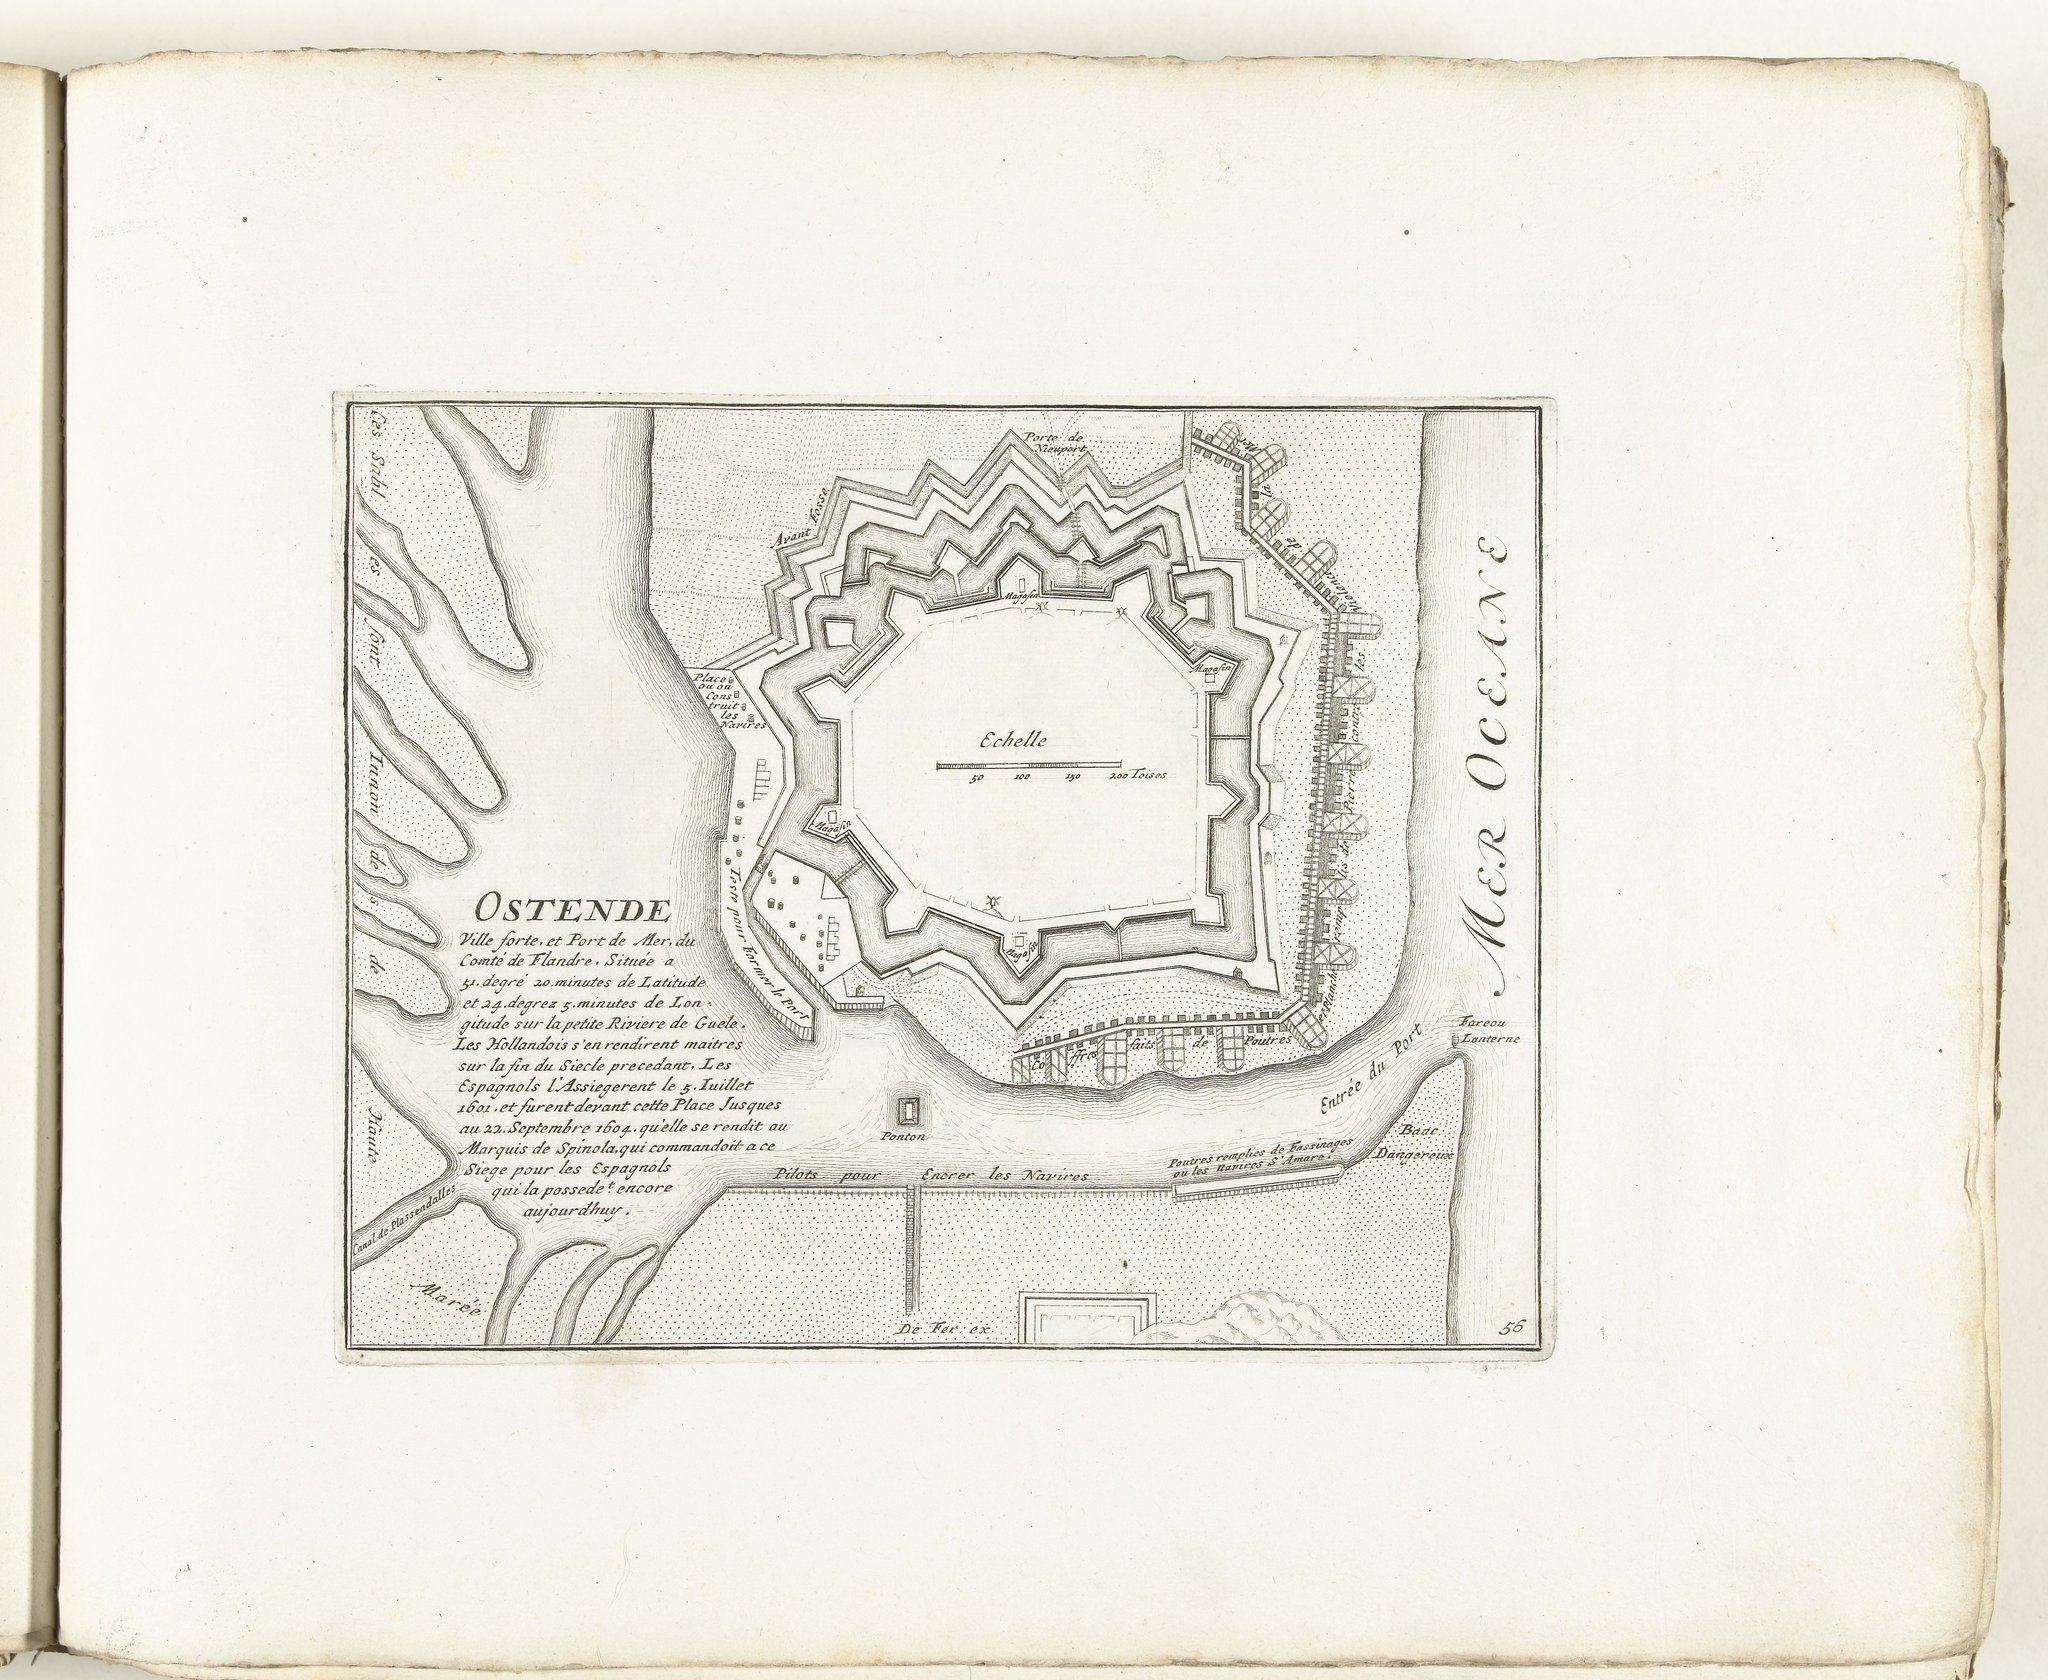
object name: print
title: Plattegrond van Oostende, ca. 1702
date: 1702-1703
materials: paper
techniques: etching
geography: amsterdam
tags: fortress, maps of cities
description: Plattegrond van de verdedigingswerken om de stad Oostende. Plaat nr. 56 in het prentwerk bestaande in totaal uit 276 genummerde platen van vermaarde sterke steden en vestingen in het kader van de Spaanse Successieoorlog. Voor het merendeel zijn deze platen gekopieerd naar de anonieme Franse platen: in Les forces de l'Europe en in: Le theatre de la guerre, dans les Pays-Bas, beide oorspronkelijk uitgegeven door Nicolas de Fer te Parijs (1693-1697) in het kader van de Negenjarige Oorlog. Titel en opschriften in de plaat in het Frans.